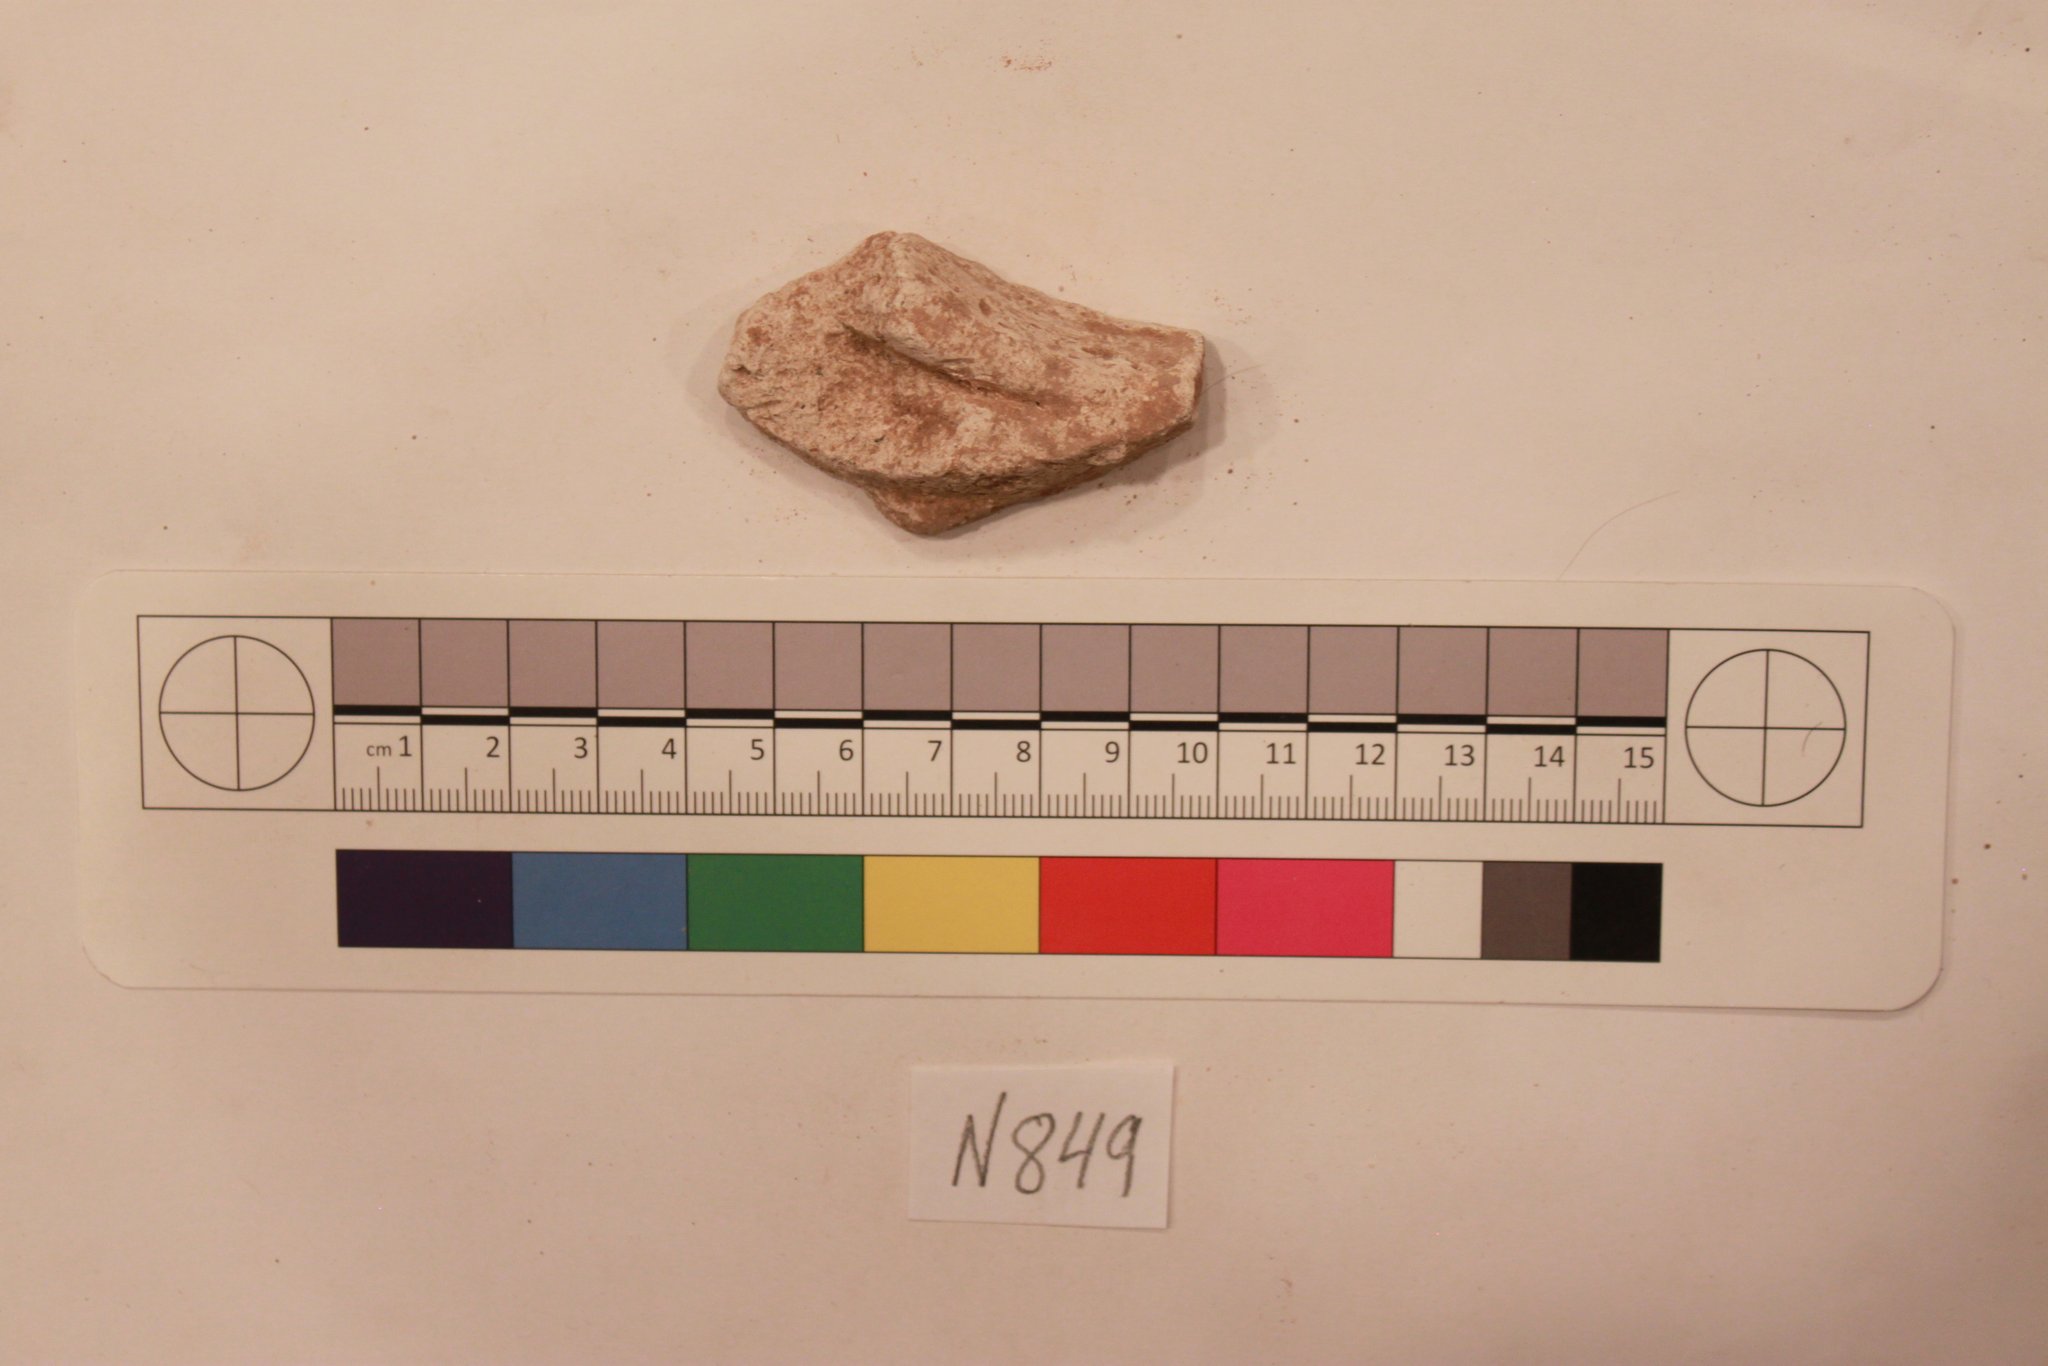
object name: fragment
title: Stucco Fragment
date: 701-1200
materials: plaster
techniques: carving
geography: iran